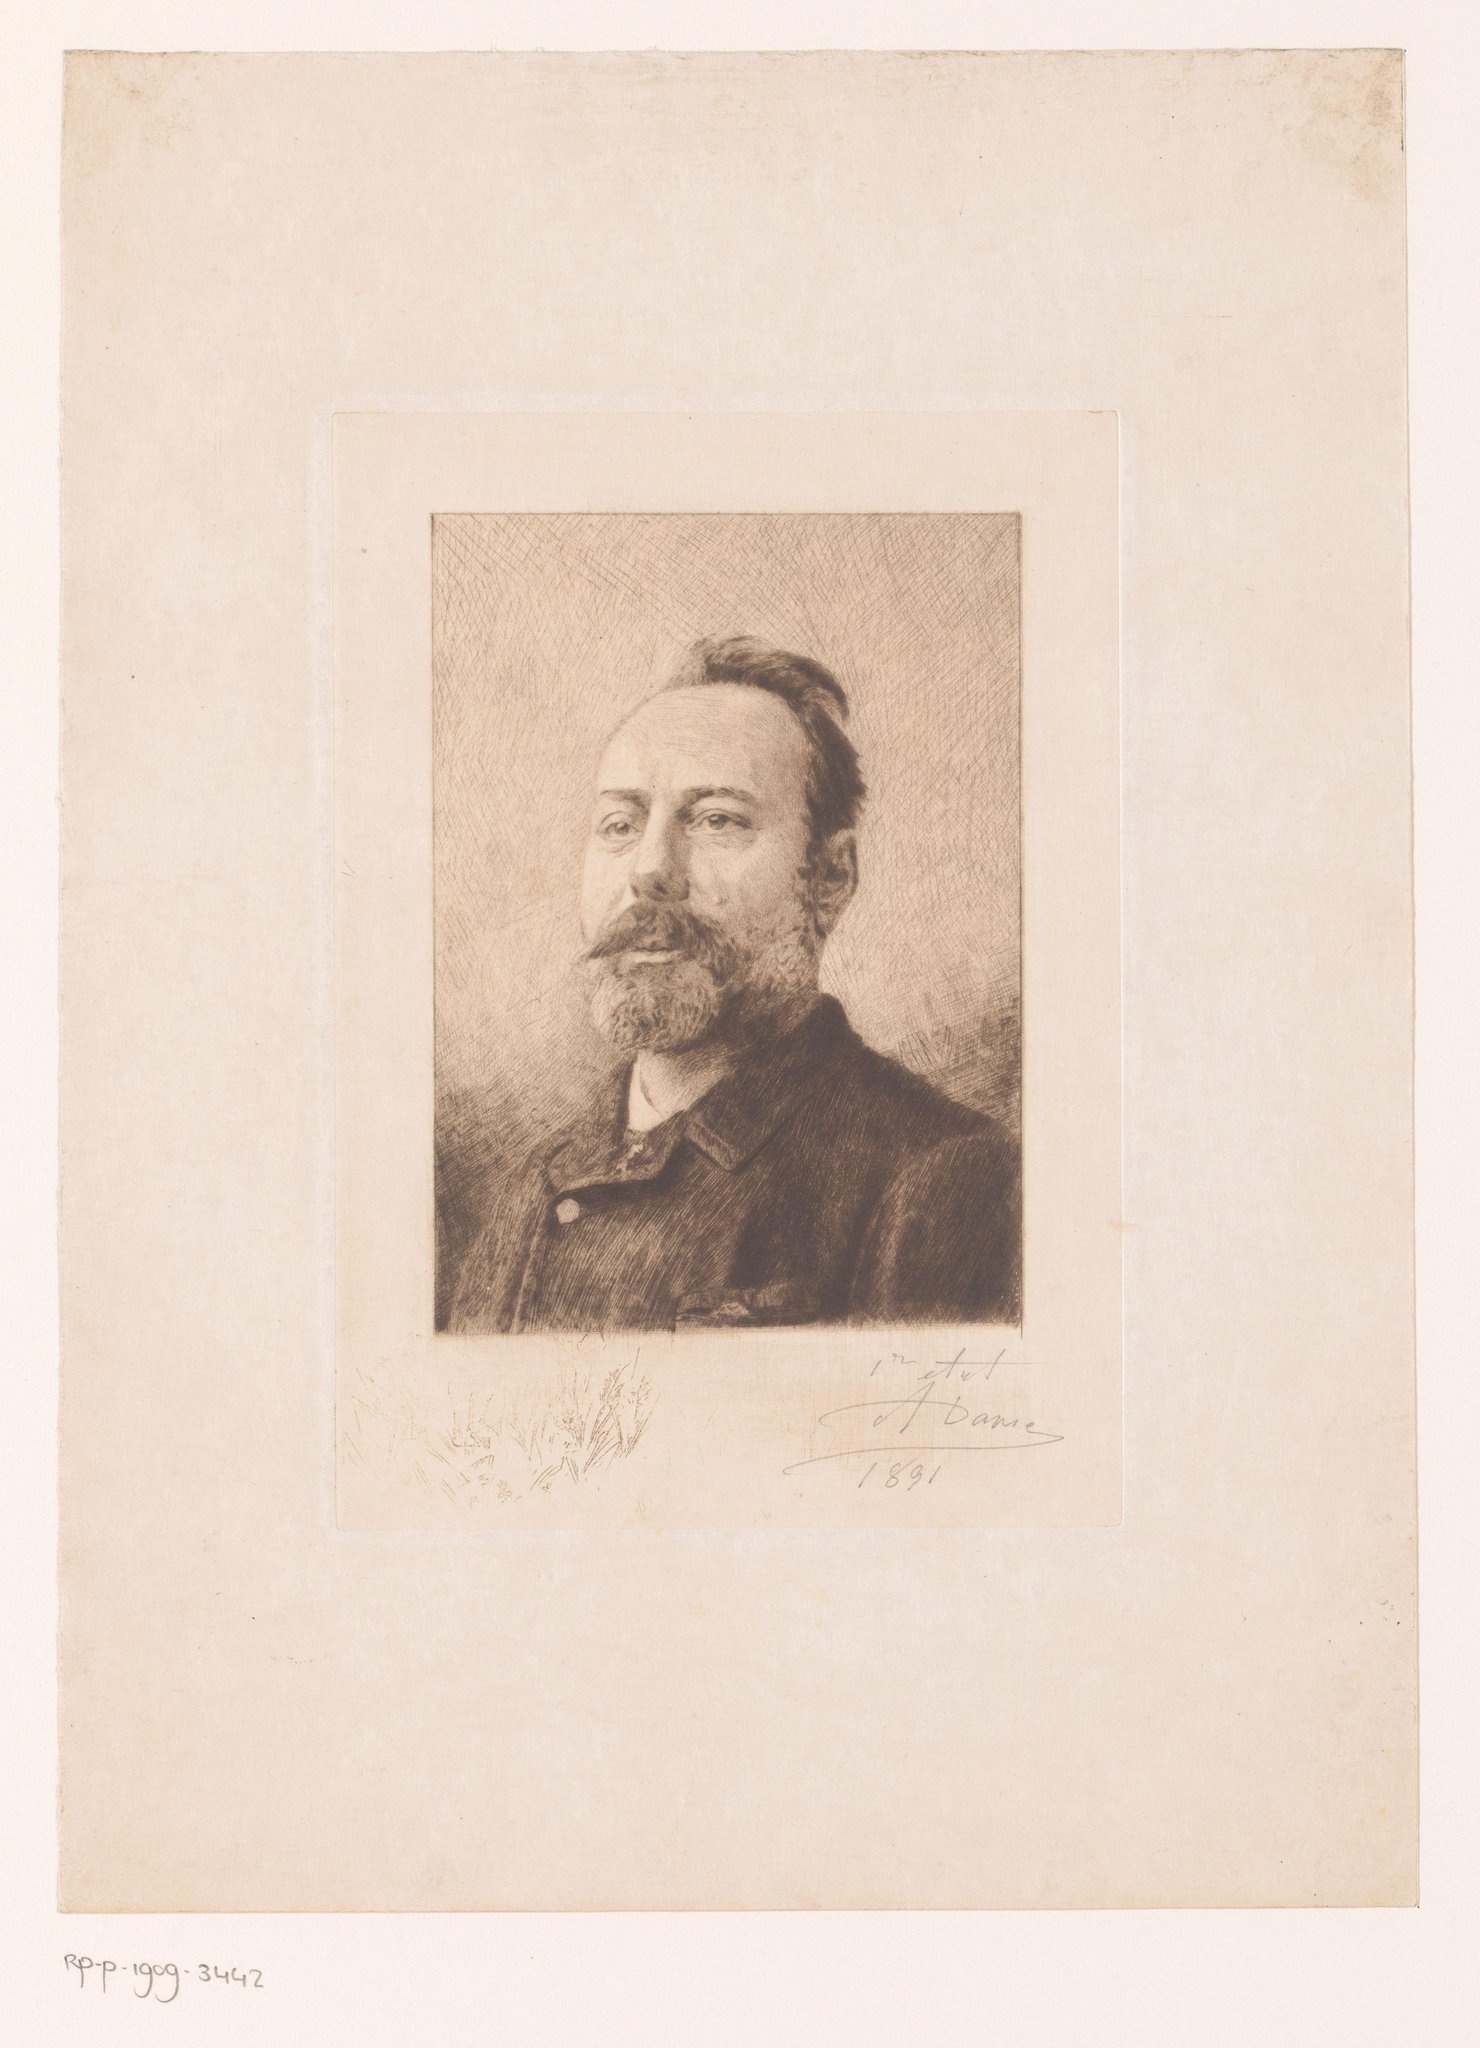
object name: print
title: Portret van een onbekende man, mogelijk E. Blauwart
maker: auguste danse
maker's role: print maker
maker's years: 1829-1929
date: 1891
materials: paper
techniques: drypoint, etching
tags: anonymous historical person portrayed alone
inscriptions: collector's mark: Lugt 2228, annotation: ‘1er etat’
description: De naam E. Blauwart staat in de marge van een ander exemplaar in de collectie van het Rijksmuseum.